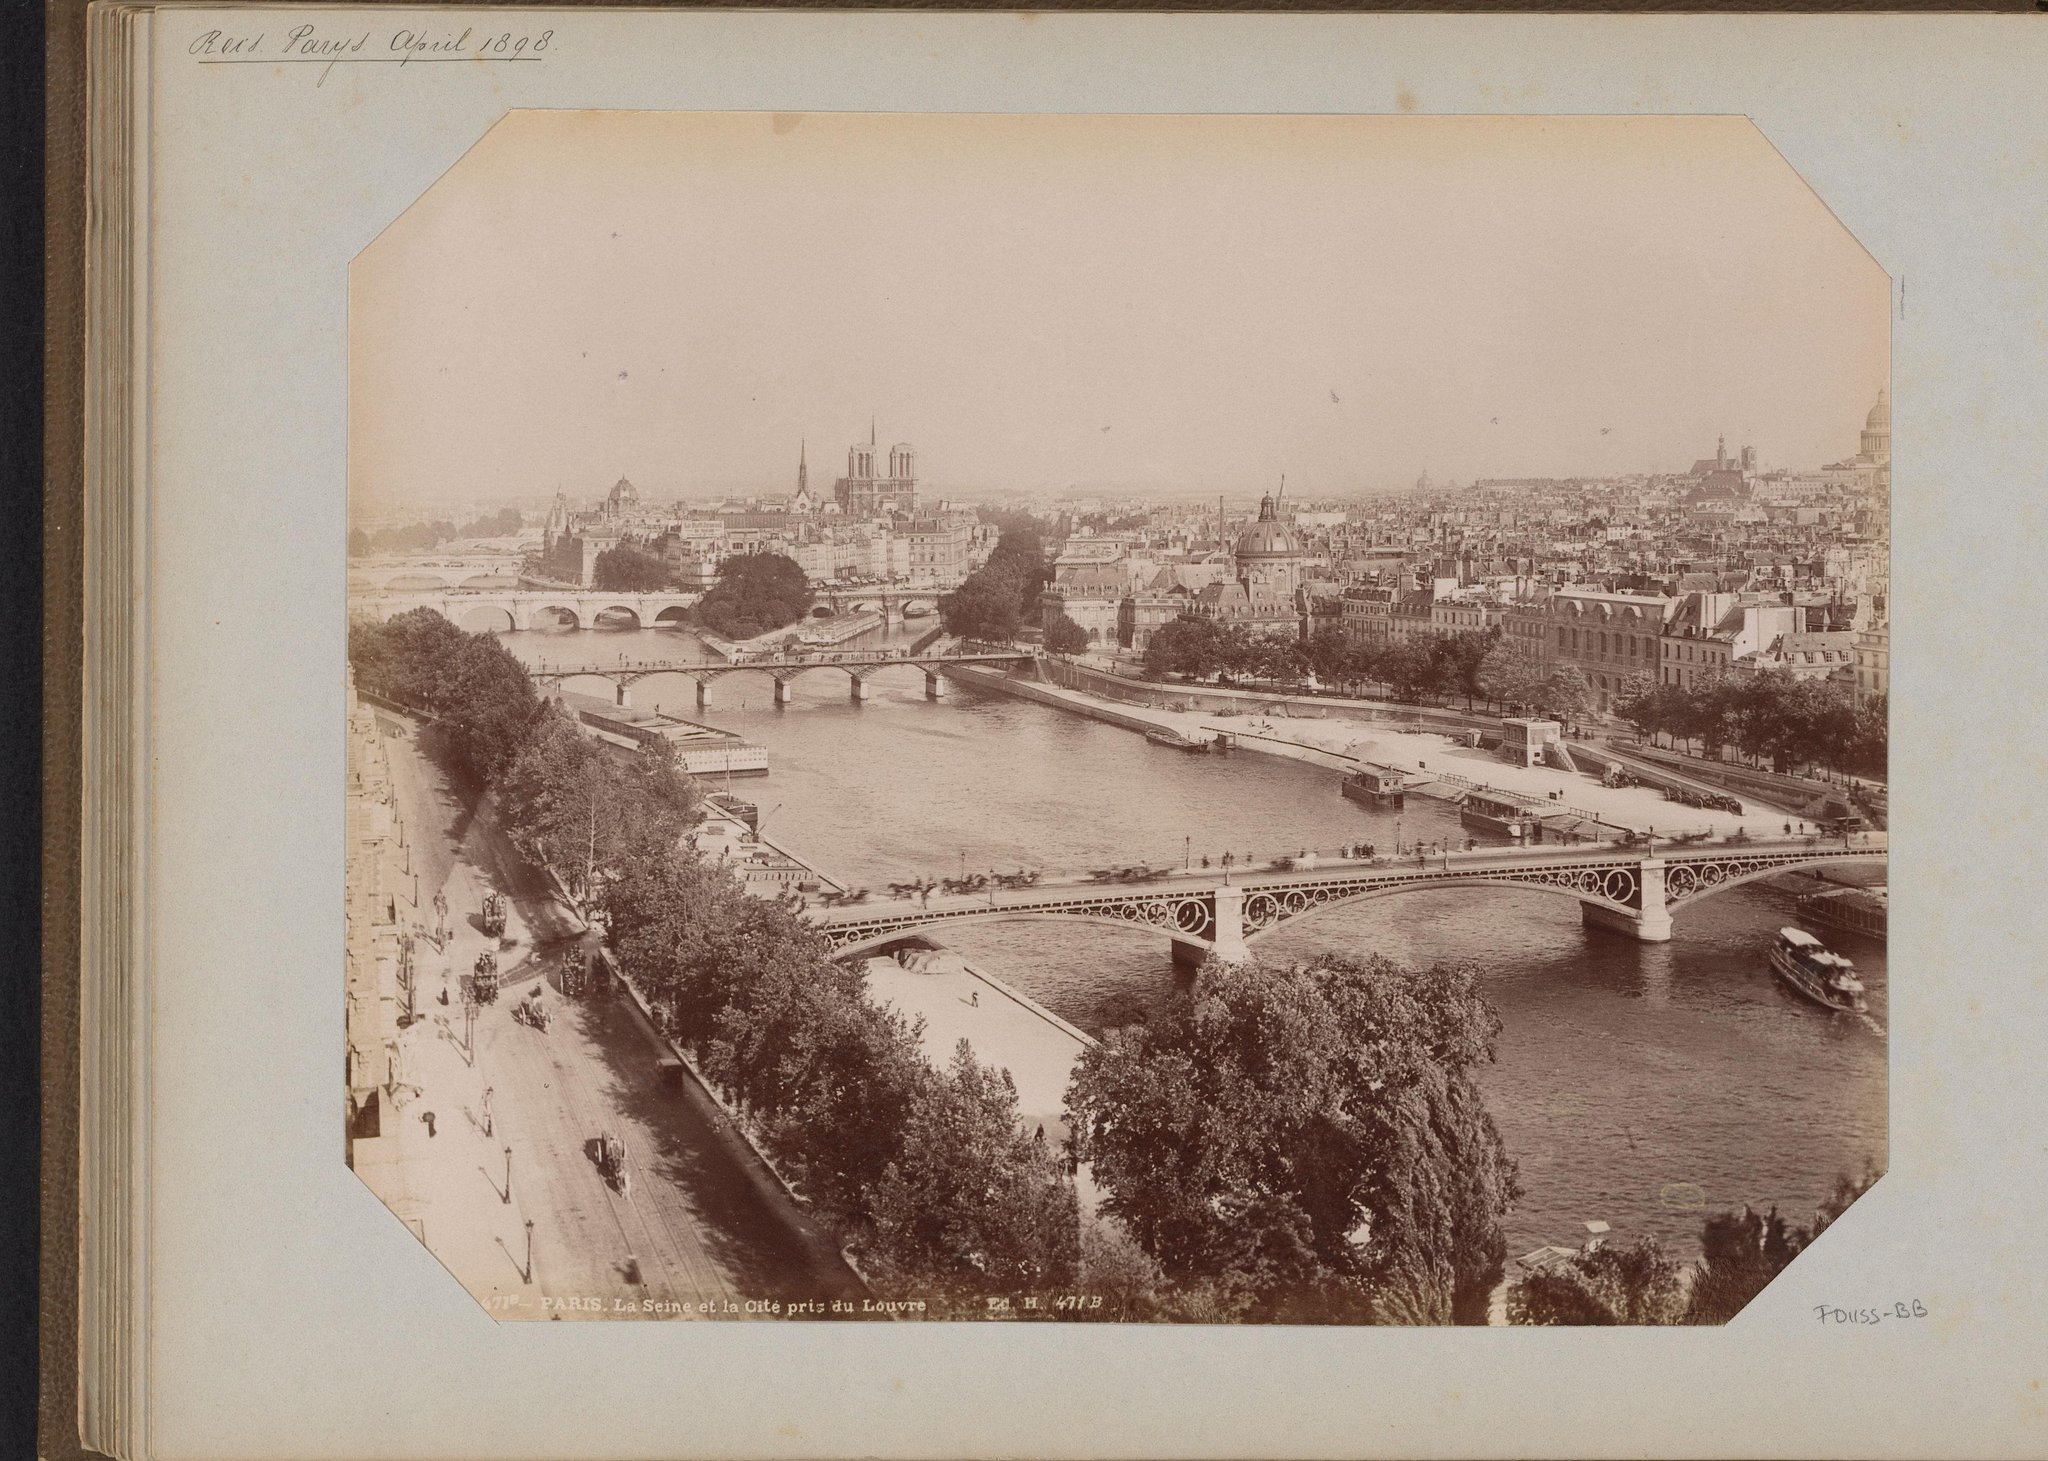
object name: photograph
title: Gezicht op Parijs met de Notre-Dame en de Seine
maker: edouard hautecoer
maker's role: publisher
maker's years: 1847-1904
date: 1890-1898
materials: photographic support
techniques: albumen print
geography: paris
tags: river, church (exterior), city-view in general; 'veduta' (+ city(-scape) with figures, staffage), paris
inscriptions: retailer's mark: ‘E. Hautecoeur/ Estampes Photographies/ 35 Avenue de l'Opéra, 35/ Paris’, annotation: ‘Reis Parijs april 1898’, inscription: ‘471B - Paris. La Seine et la Cité pris du Louvre. Ed. H. 471B’